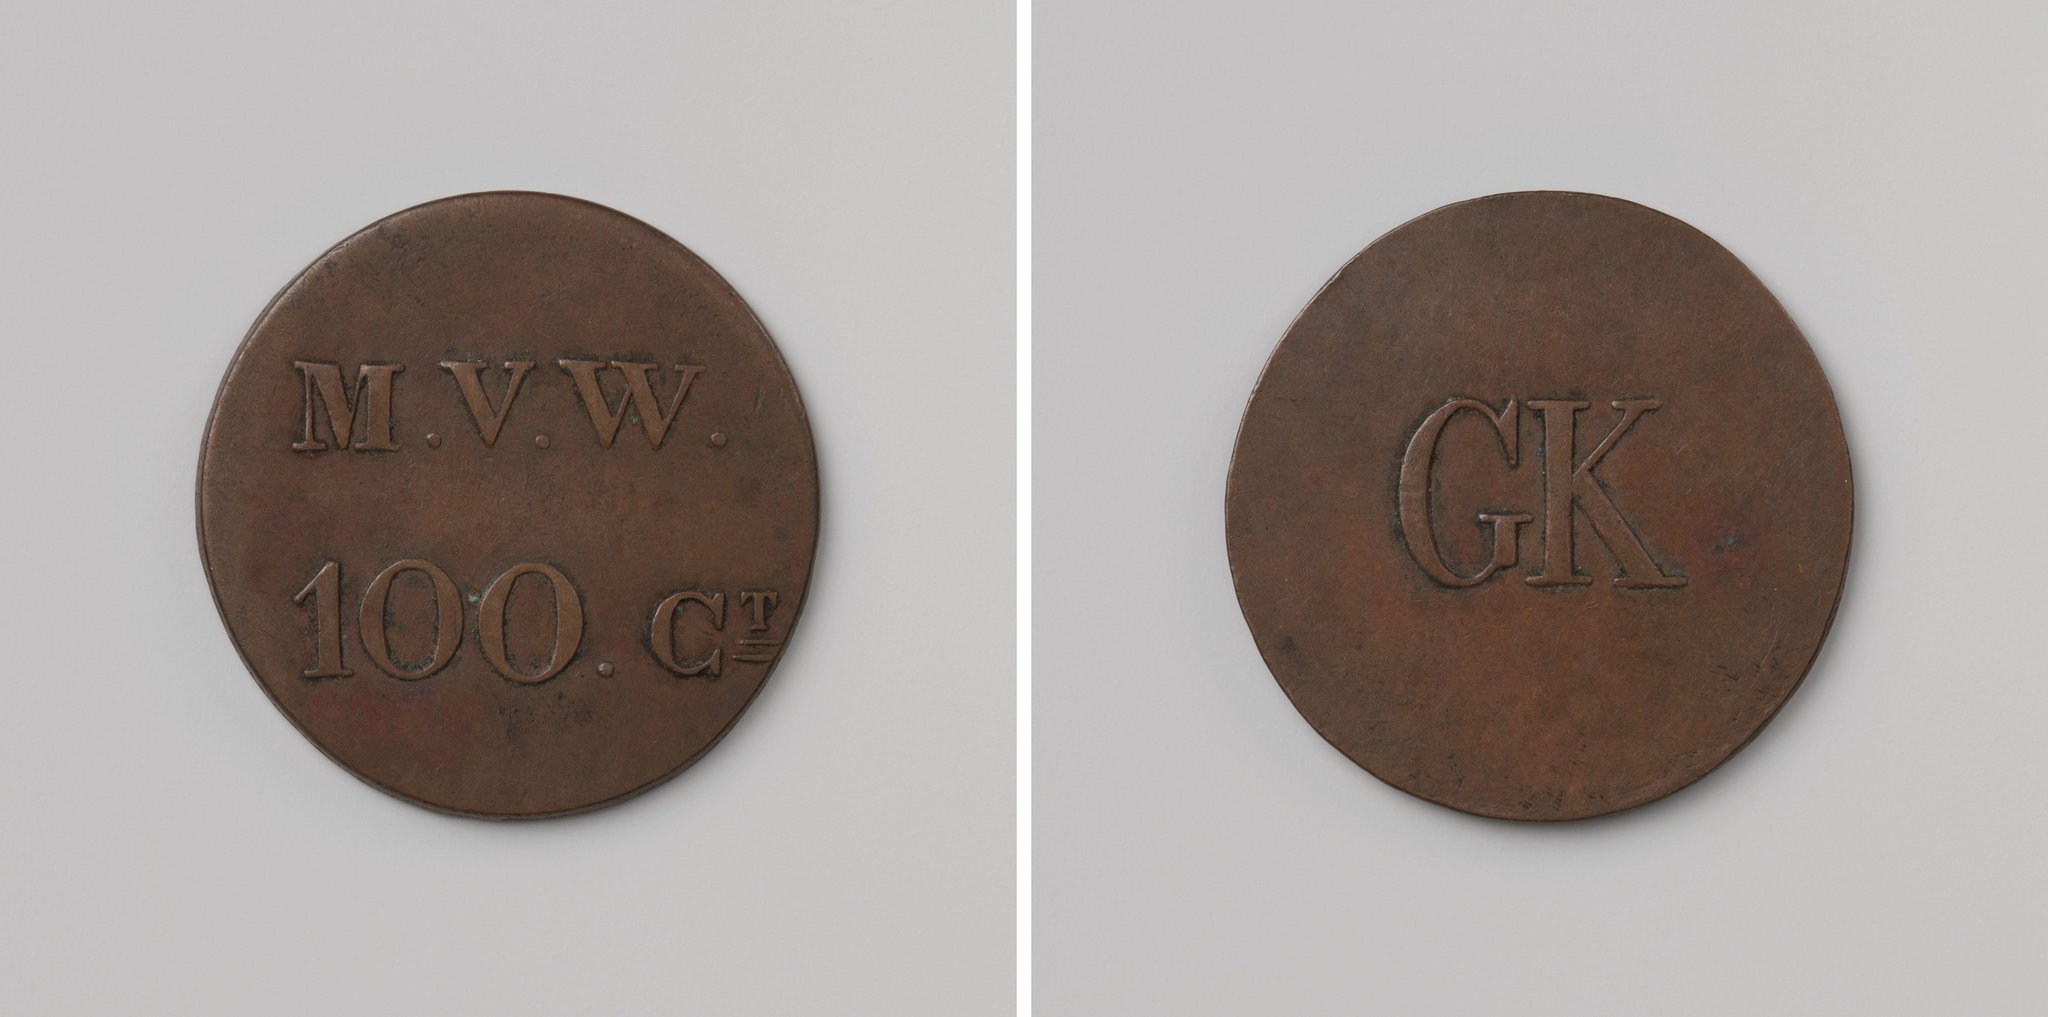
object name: monetary token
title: Huismunt geslagen op last van de Maatschappij van Weldadigheid ter waarde van 1 gulden, ten behoeve van de Gewone Koloniën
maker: Anonymous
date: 1818-1859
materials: copper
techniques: striking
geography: netherlands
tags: maatschappij van weldadigheid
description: Voorzijde: opschrift boven waardeaanduiding. Keerzijde: letters G en K